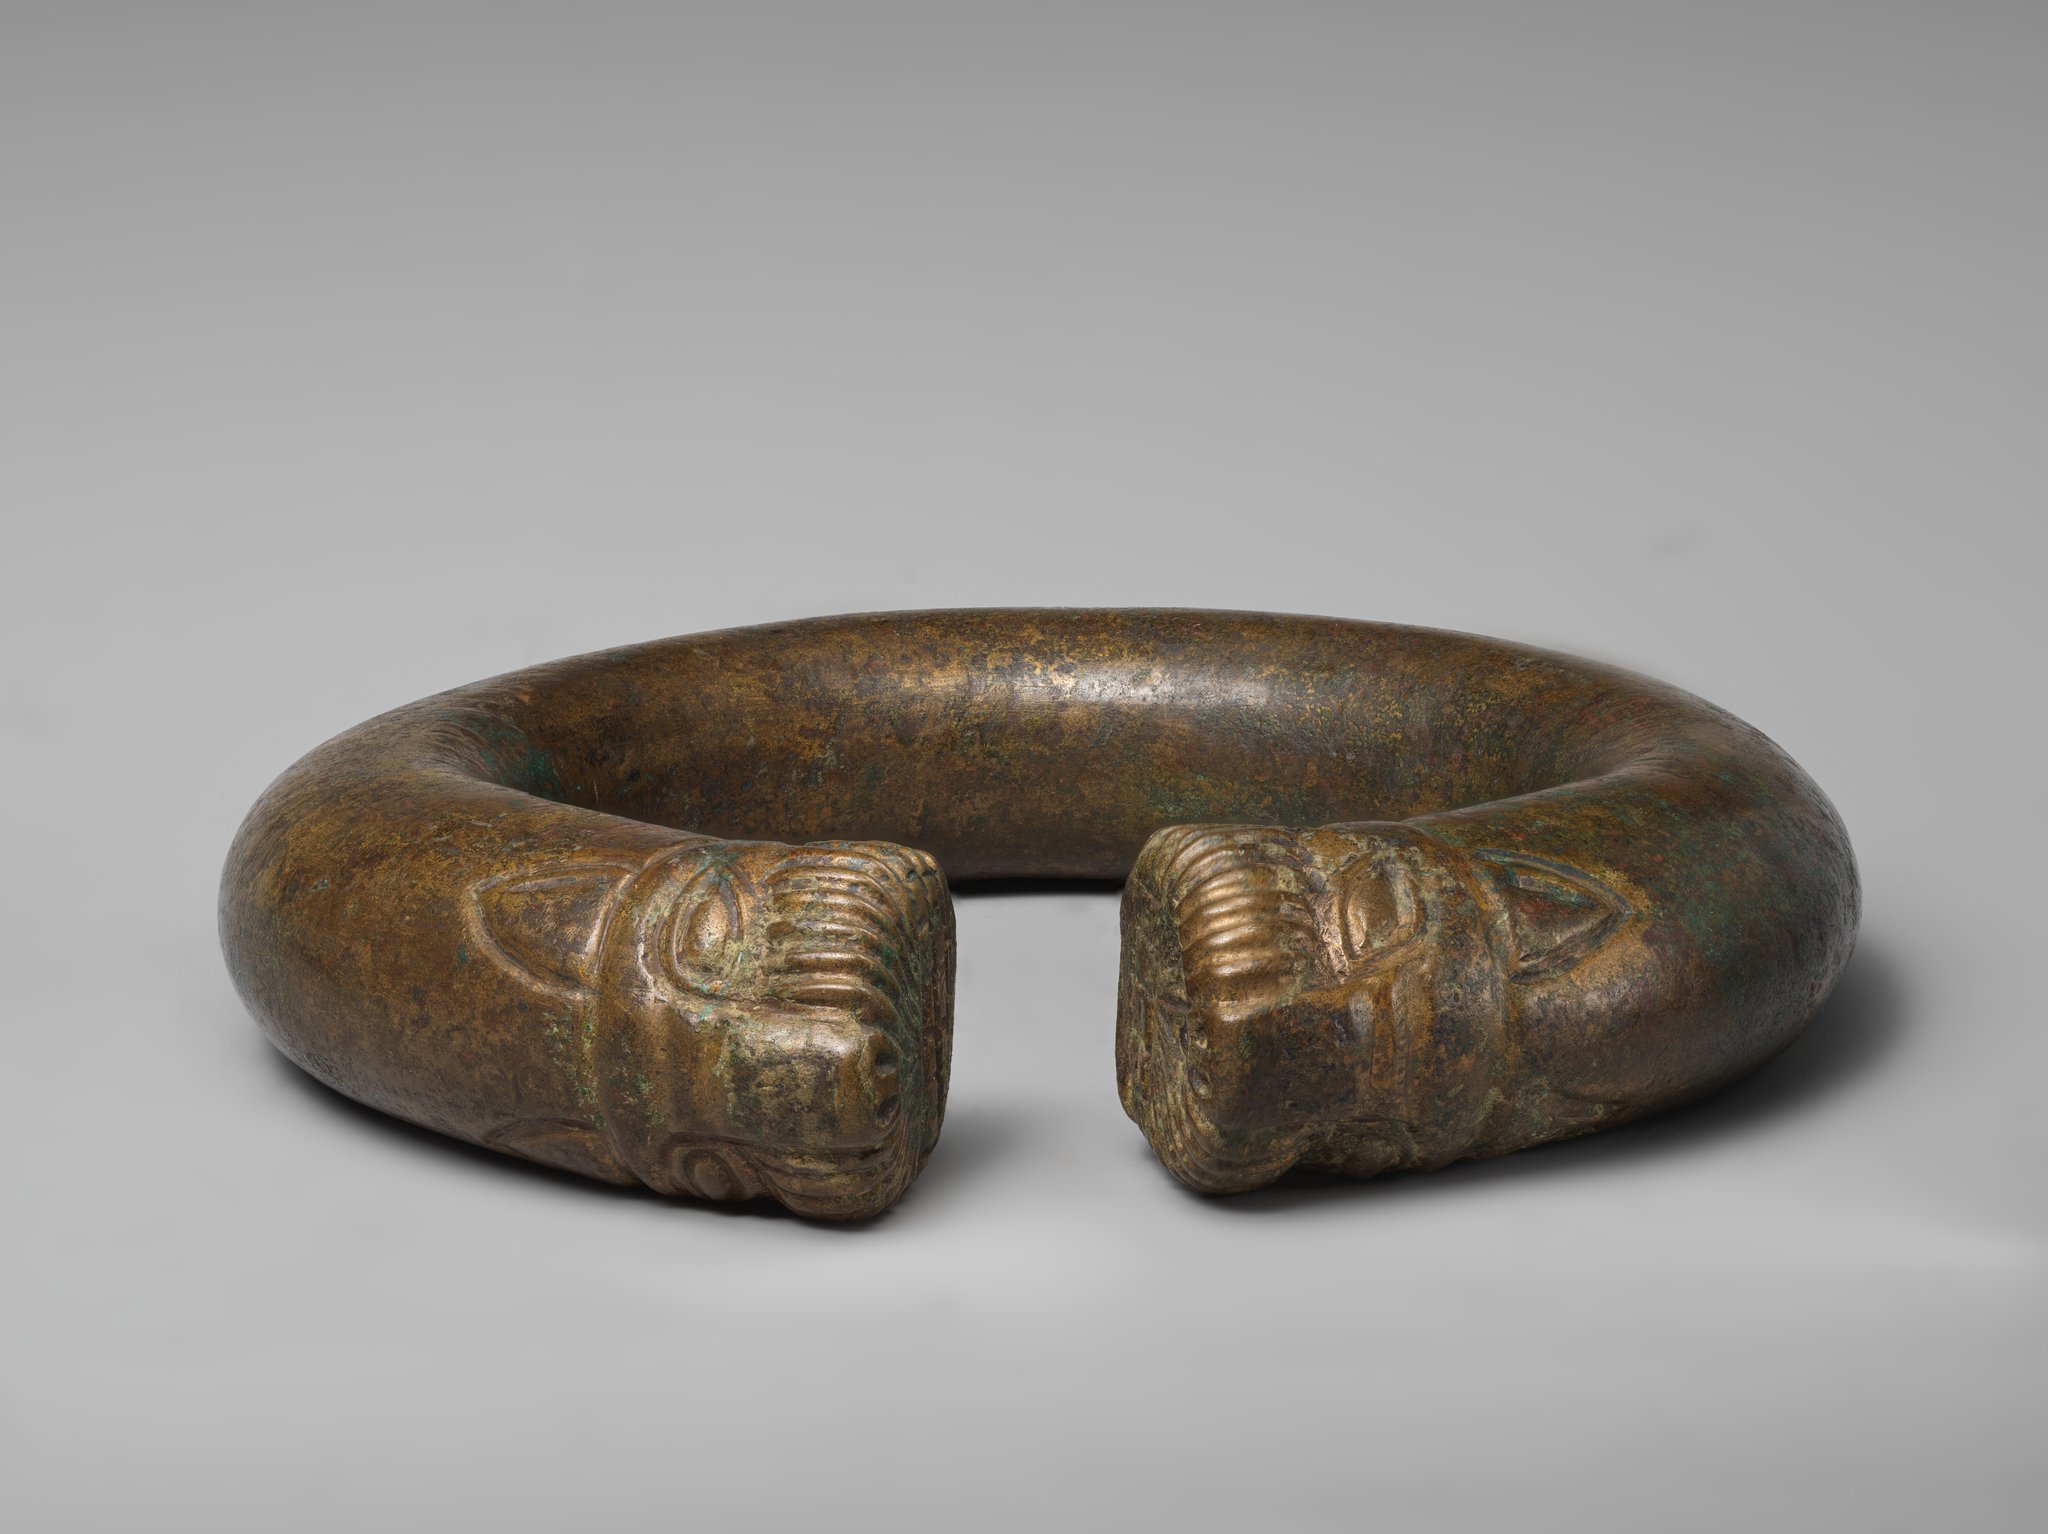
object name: bracelet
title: Bracelet or anklet with lions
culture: iranian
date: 800-601 BCE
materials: bronze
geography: iran, probably from luristan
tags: lions